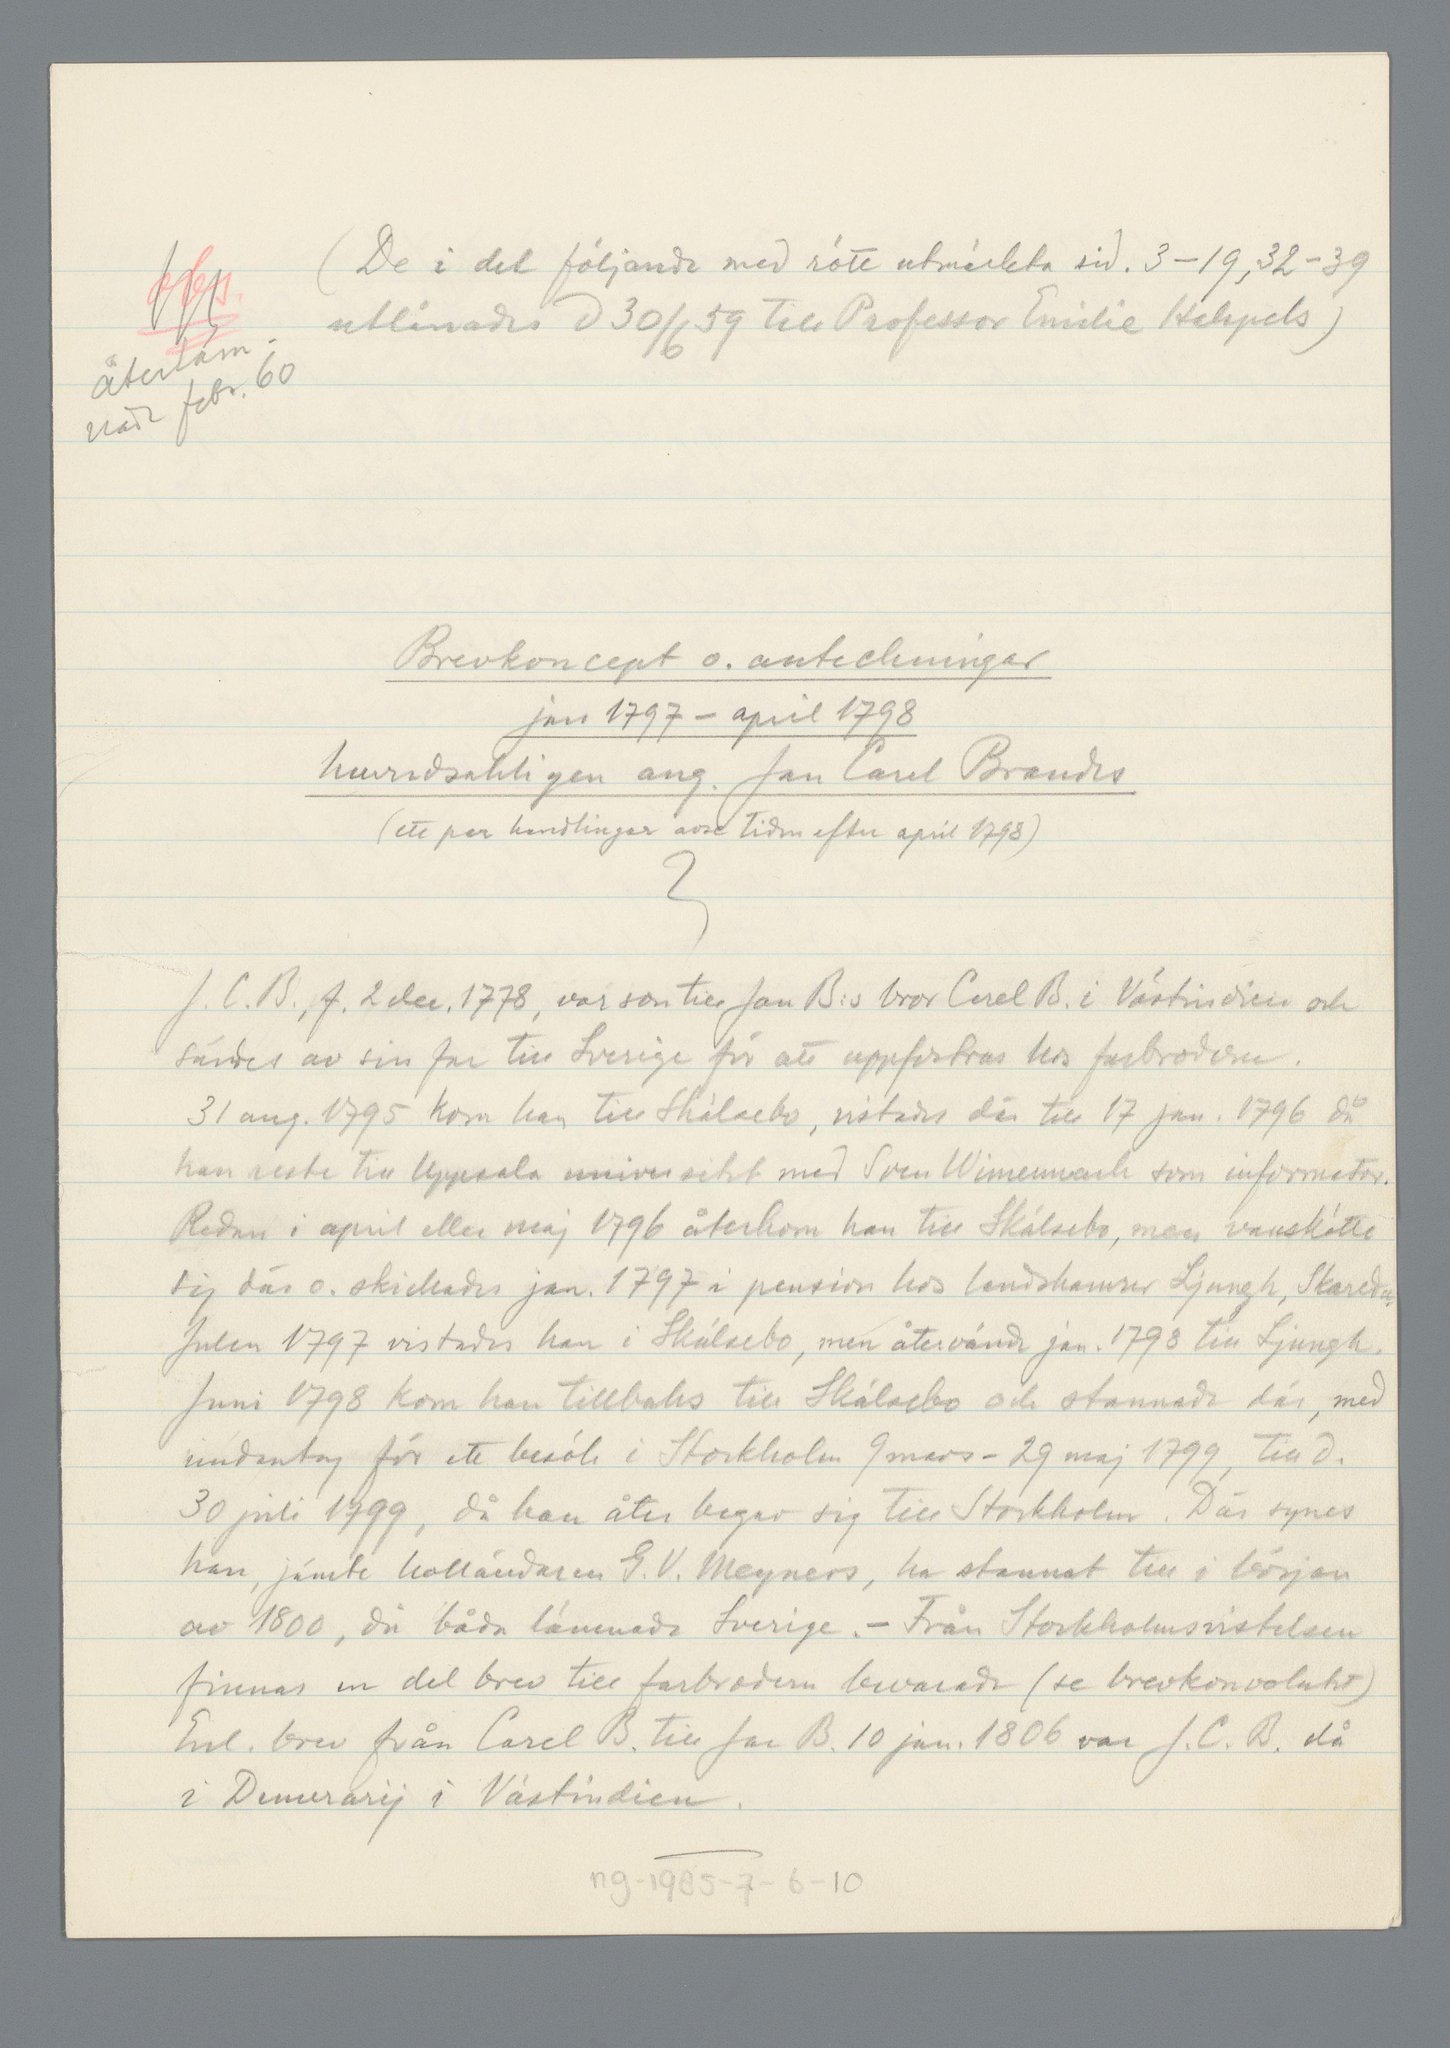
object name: letter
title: Kladbrievenboek Jan Brandes (1743-1808), 1797-1798.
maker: jan brandes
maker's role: draughtsman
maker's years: 1743-1808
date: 1797-1798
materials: paper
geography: skälsebo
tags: bodegraven, draughtsman, jan brandes